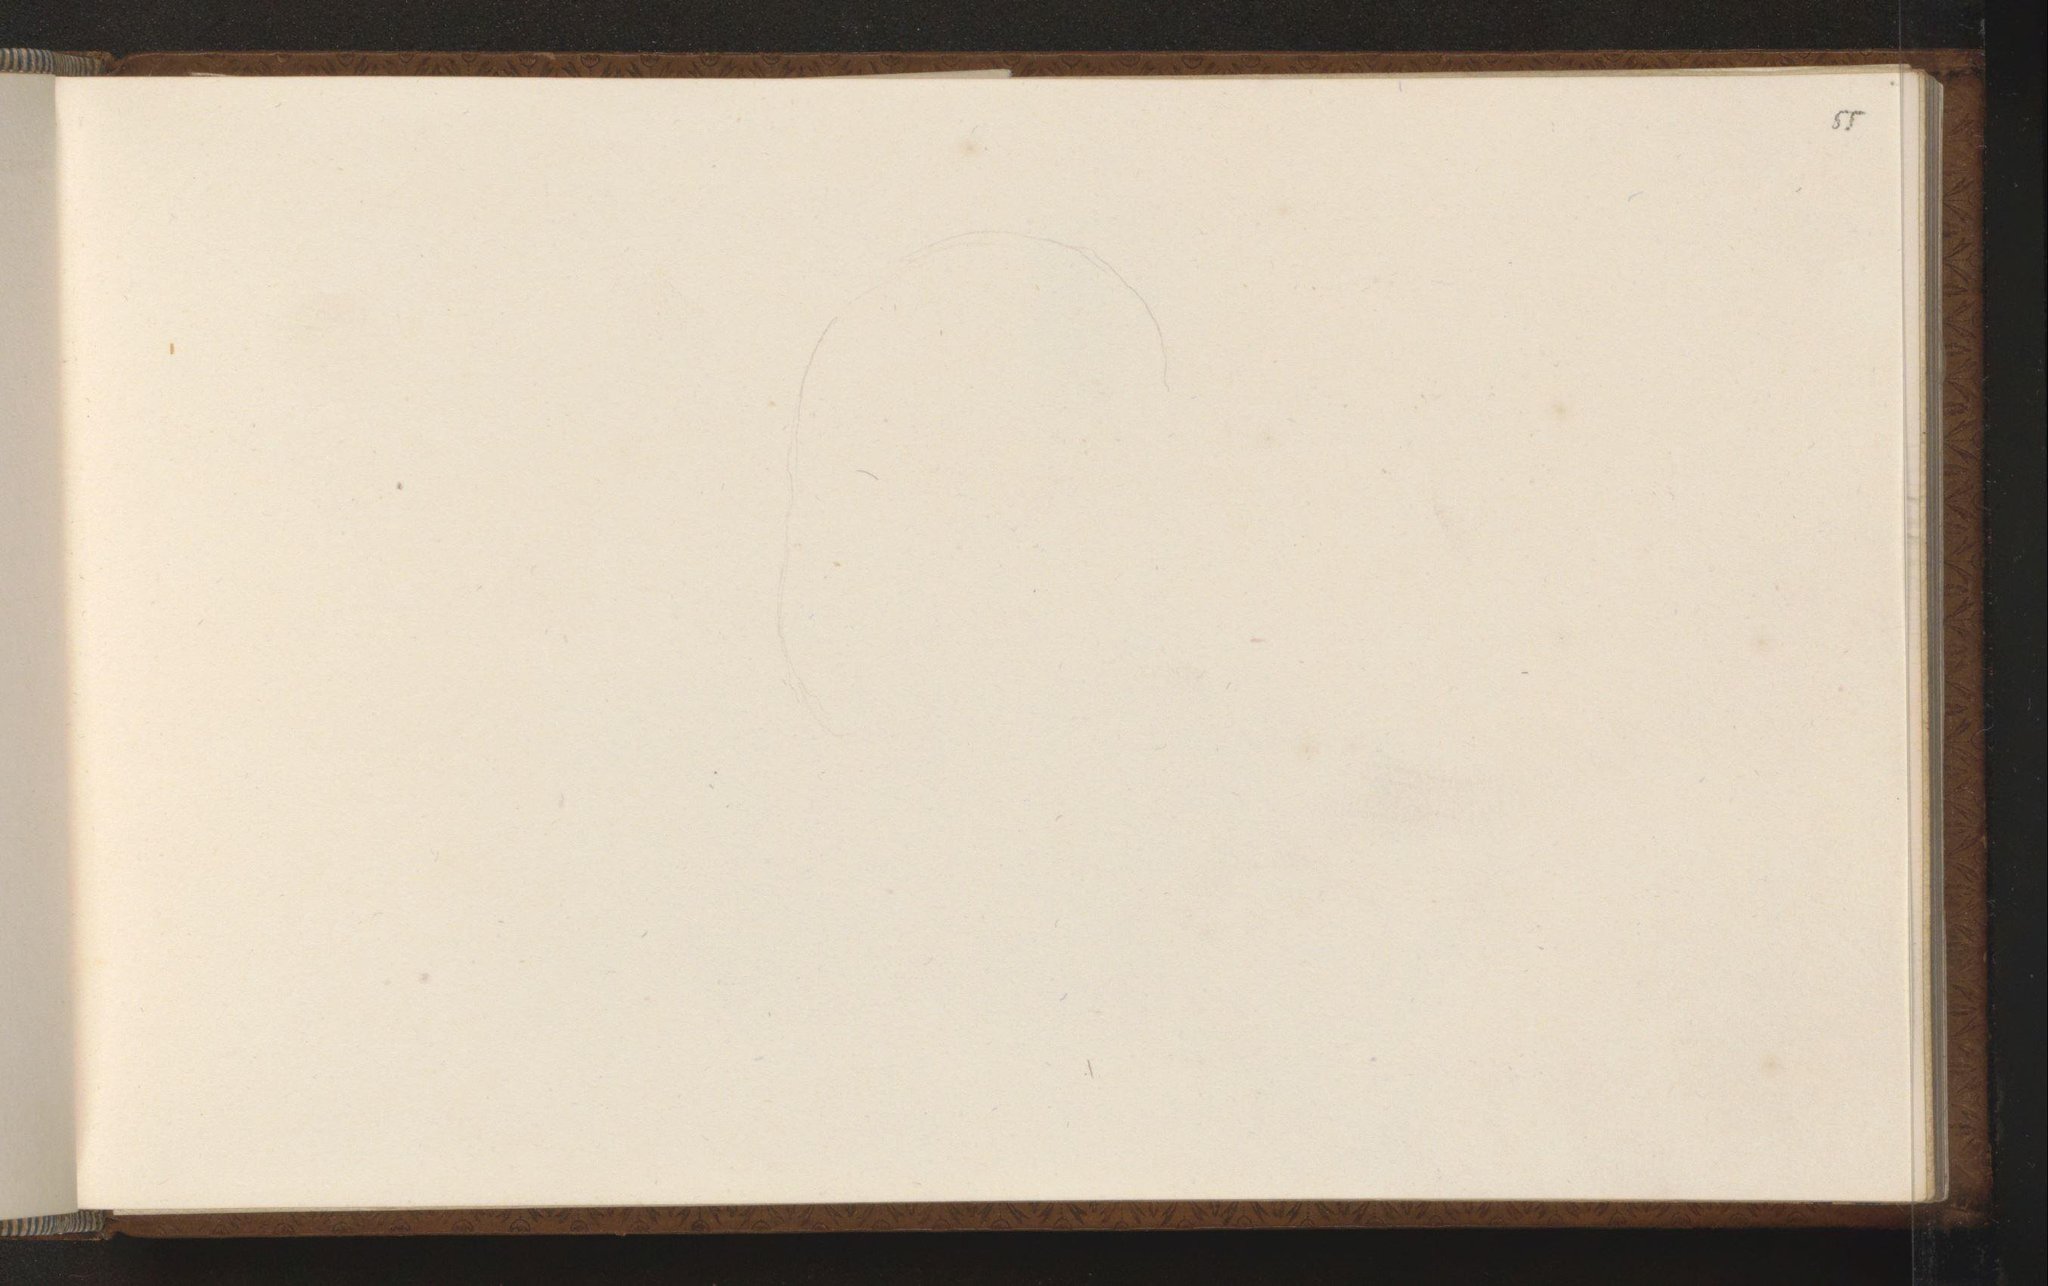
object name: sketchbook leaf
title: Kop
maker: christian heinrich gottlieb steuerwald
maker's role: draughtsman, print maker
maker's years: 1802-1874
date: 1834-1844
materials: paper, pencil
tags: head (human)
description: Bladzijde 55 uit een schetsboek met 188 bladzijden.